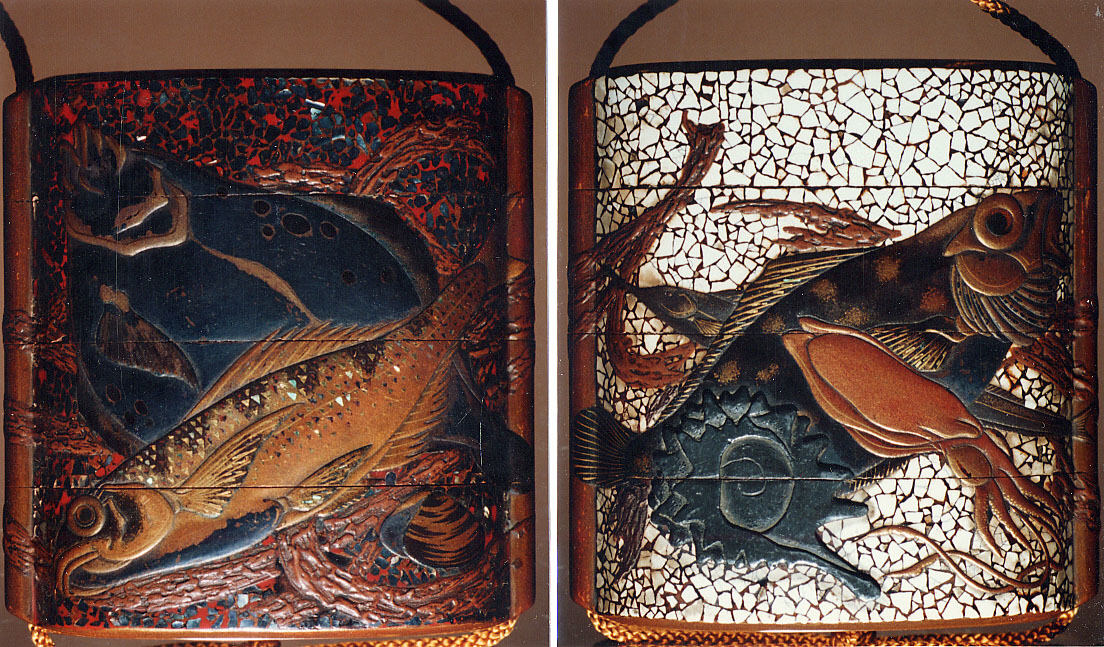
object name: inrō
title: Case (Inrō) with Design of Various Fishes, Squid and Shells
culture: japanese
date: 1801-1900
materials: gold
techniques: fundame, hiramakie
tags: fish,shells